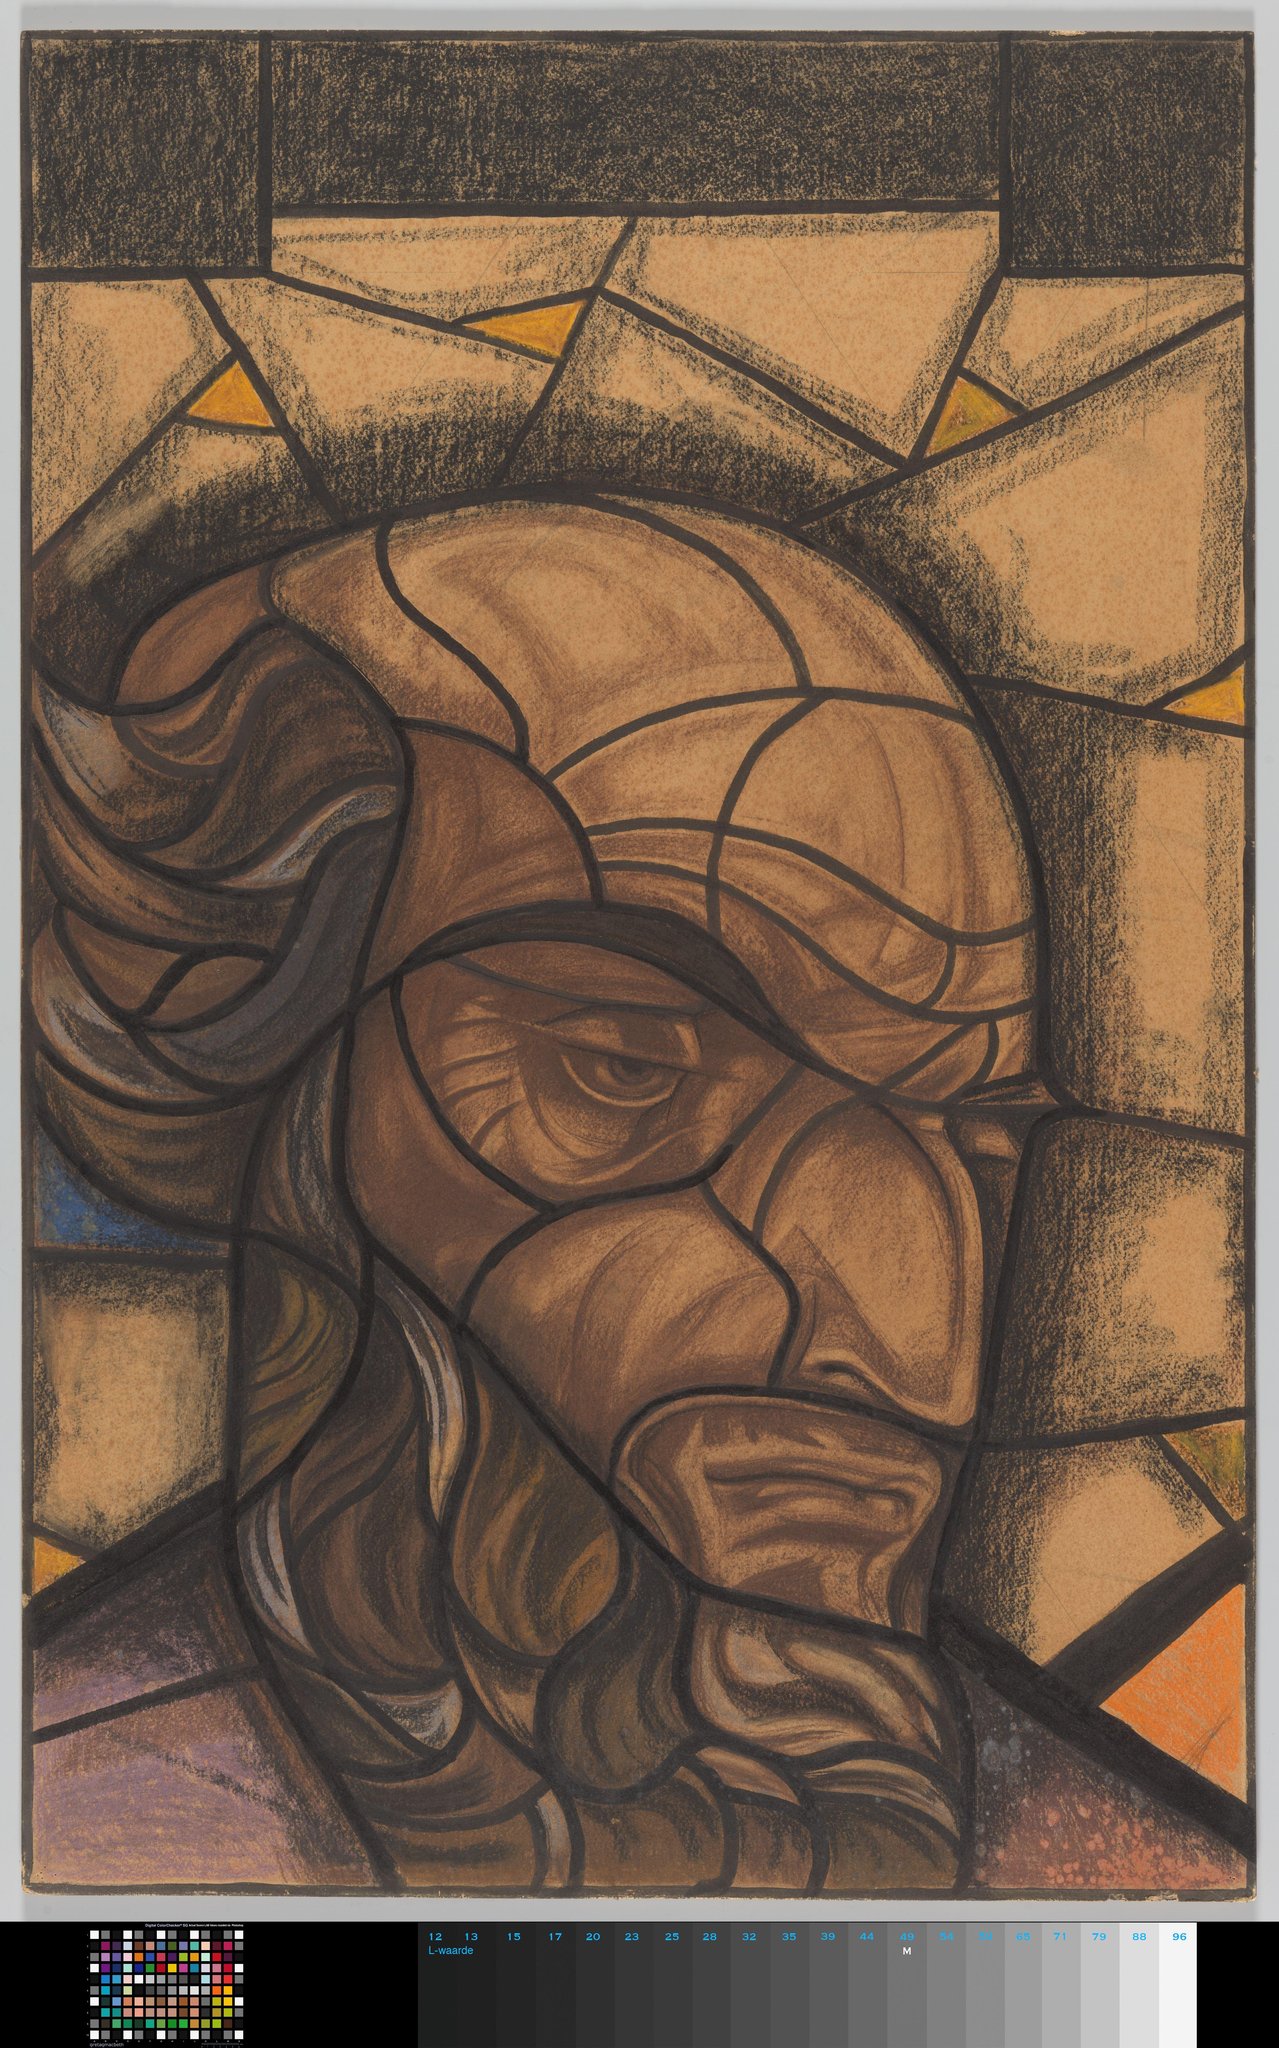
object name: design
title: Ontwerp voor raam in het Zuidertransept van de Dom te Utrecht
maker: richard nicolaüs roland holst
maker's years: 1868-1938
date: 1878-1938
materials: cardboard, chalk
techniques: brush